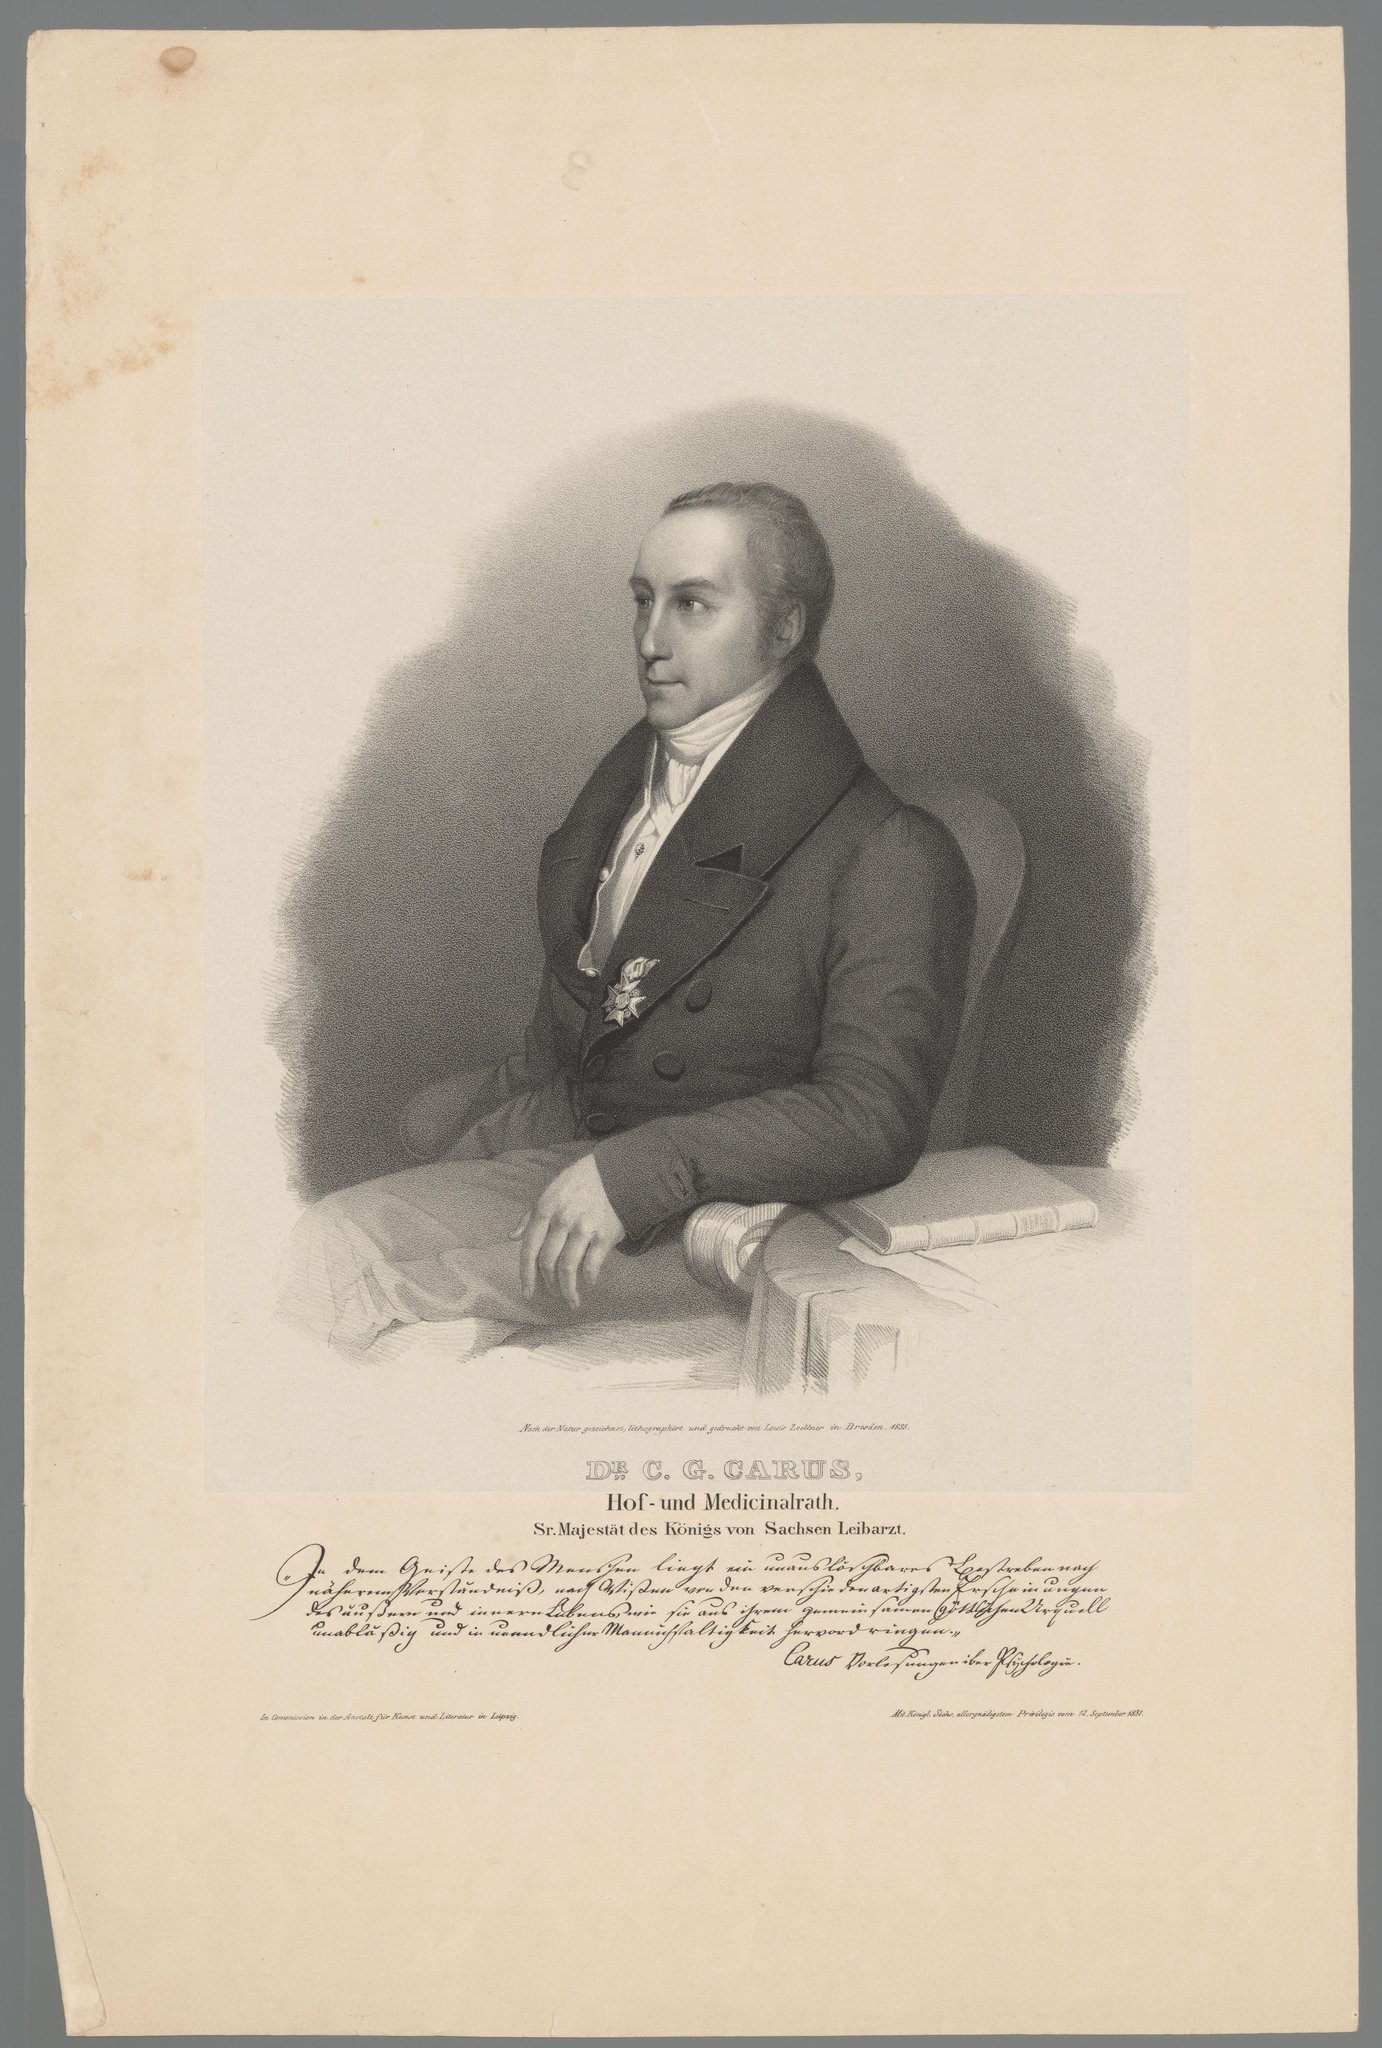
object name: print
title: Dr. C.G. Carus, Hof- und Medicinalrath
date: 1833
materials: paper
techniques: lithograph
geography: dresden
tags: armchair, seat, adult man, historical persons, book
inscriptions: collector's mark: Lugt 2228